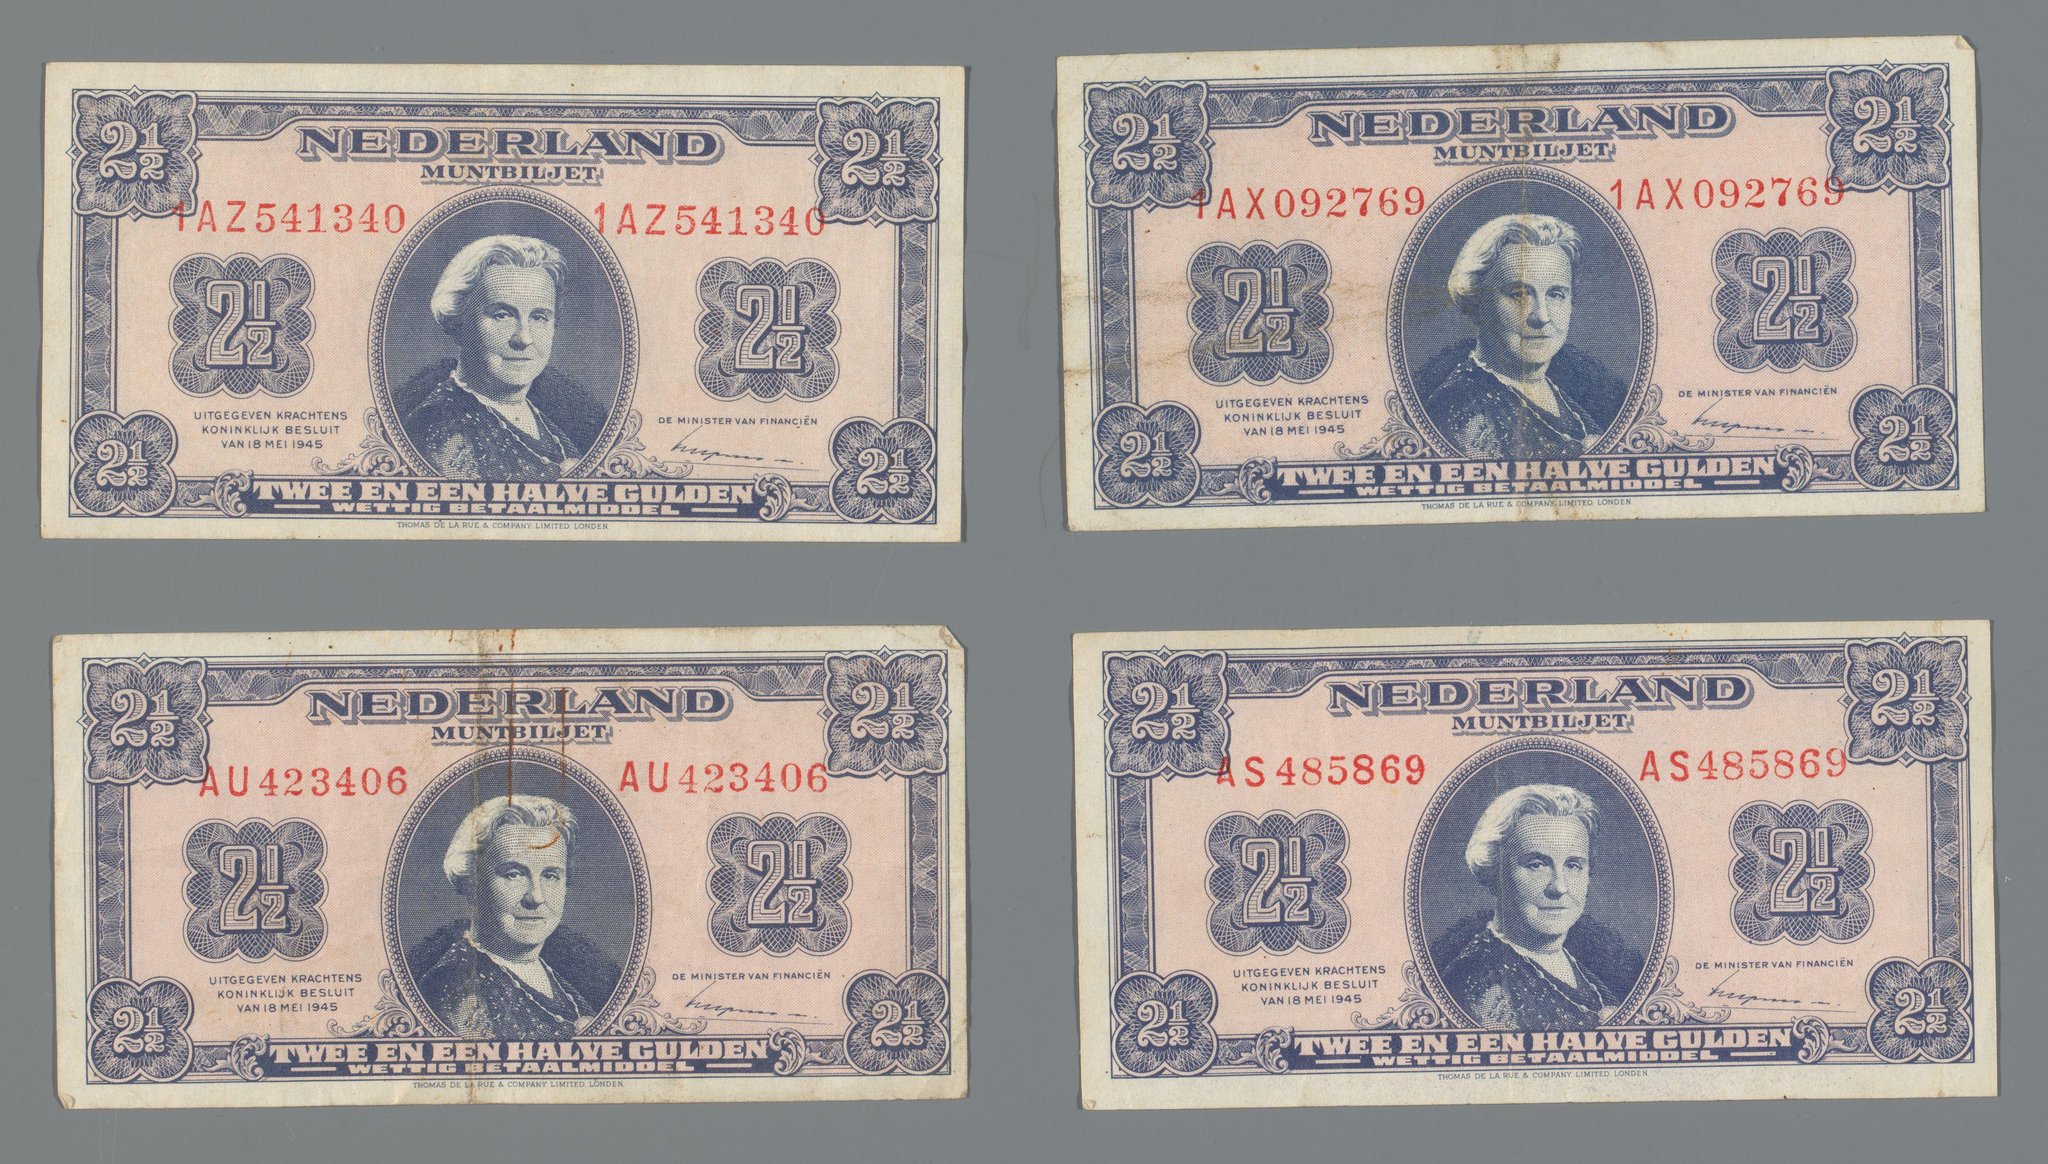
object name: twee en een halve gulden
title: Twee en een halve gulden muntbiljet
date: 1945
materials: paper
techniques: printing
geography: london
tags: tweede wereldoorlog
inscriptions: date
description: Vier muntbiljetten à f2,50 in blauw en roze, met op de voorzijde een portret van een vrouw (Koningin Wilhelmina), en op de achterzijde het wapen van Nederland. Gesigneerd en gedateerd: voorzijde.